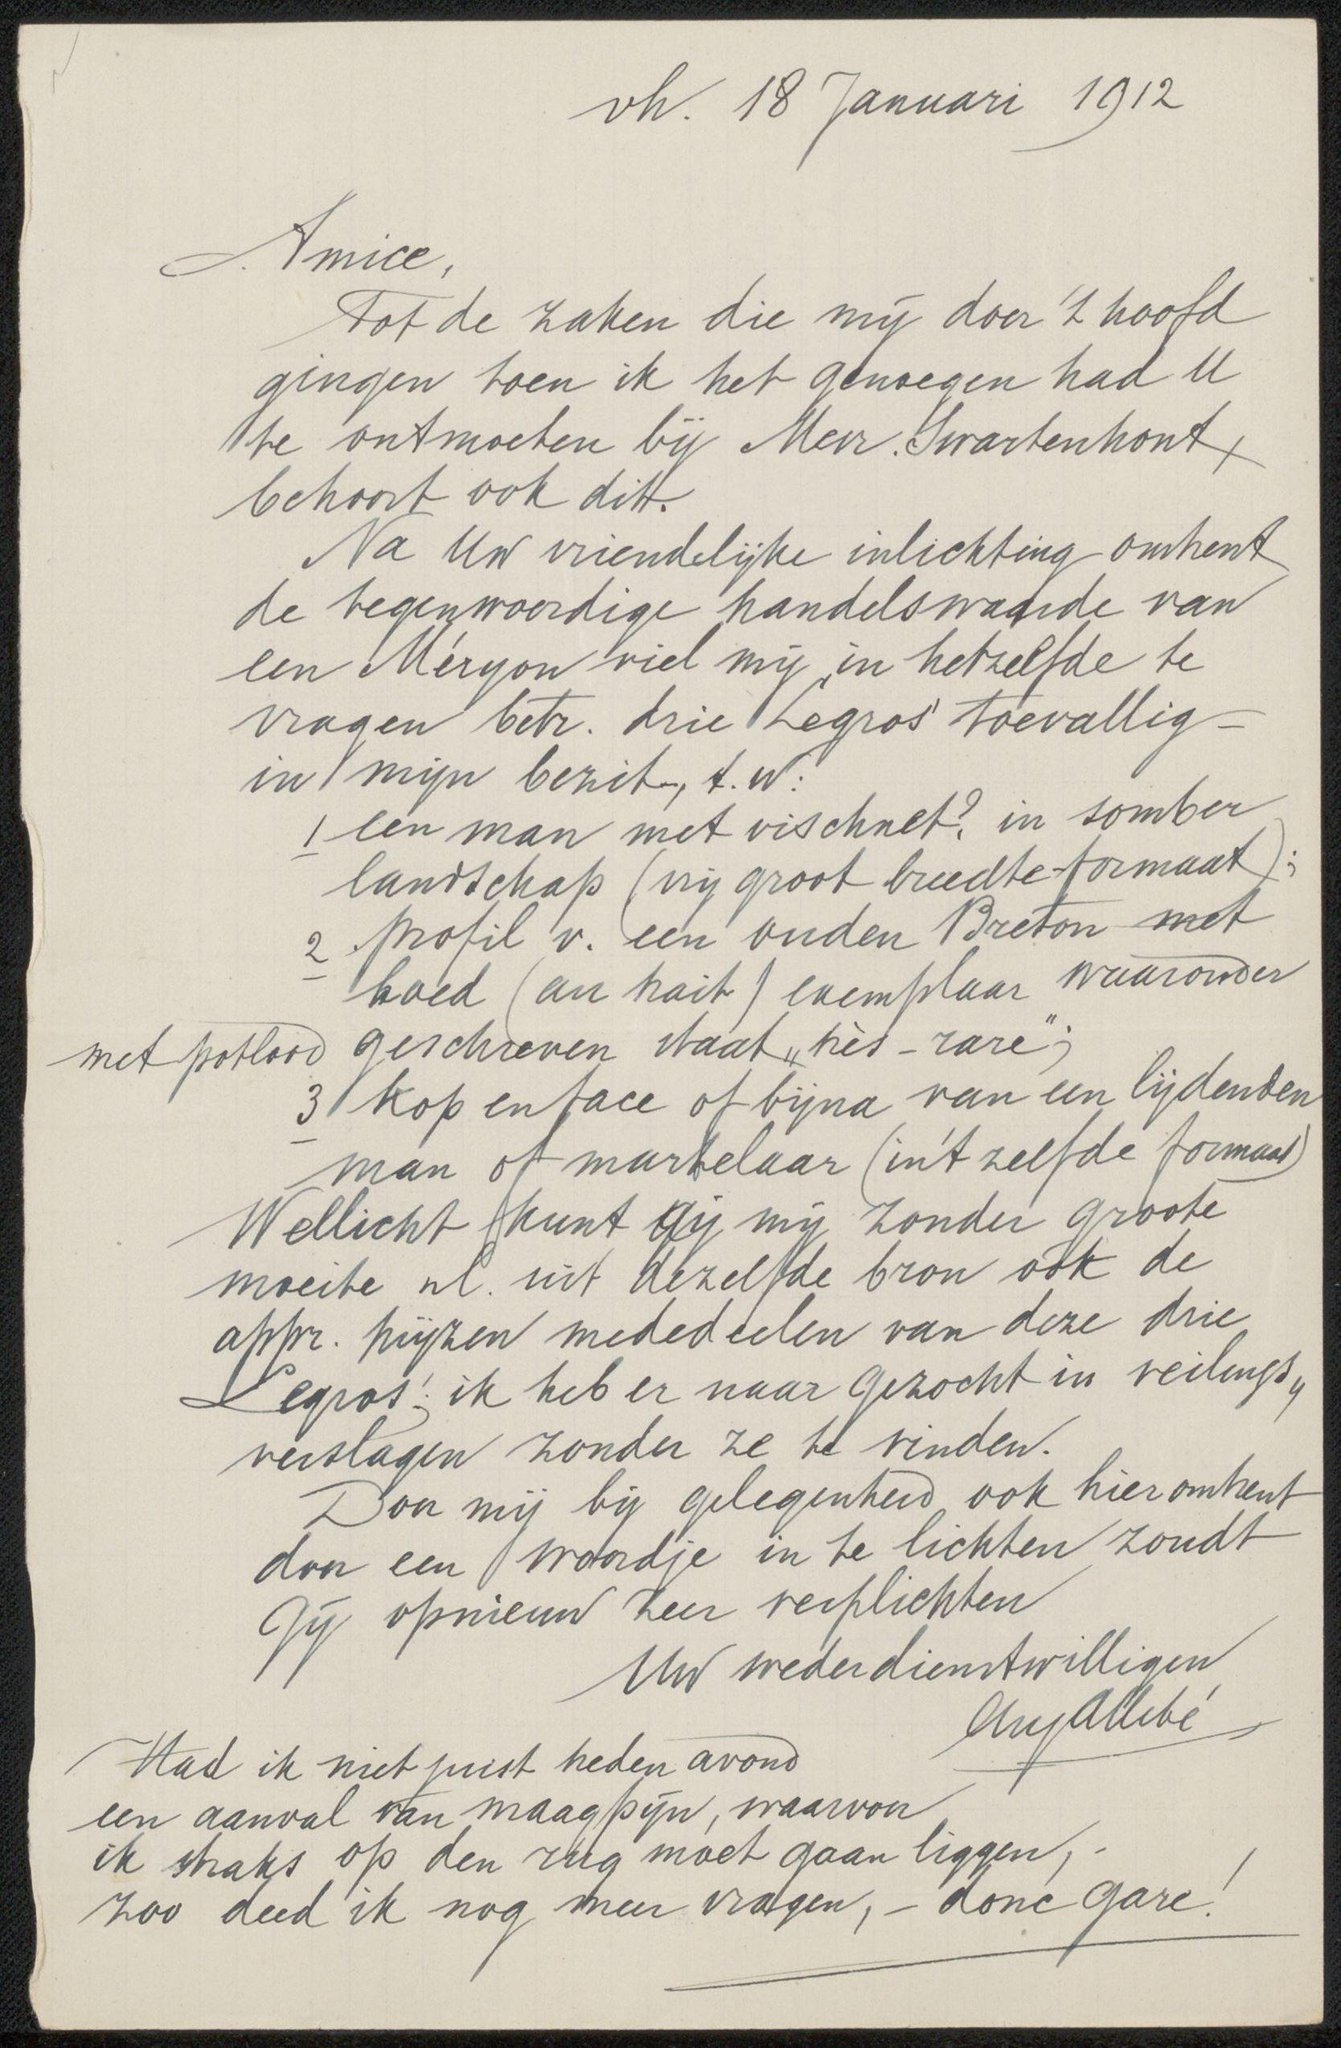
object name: letter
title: Brief aan Jan Veth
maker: august allebé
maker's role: draughtsman, print maker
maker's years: 1838-1927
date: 1912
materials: ink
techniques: pen, writing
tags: dordrecht, amsterdam, painter, draughtsman, designer, jan veth, print maker, alphonse legros, paris, charles meryon, art trade, art shop, diseases, art collecting, money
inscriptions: collector's mark: ‘RPK’